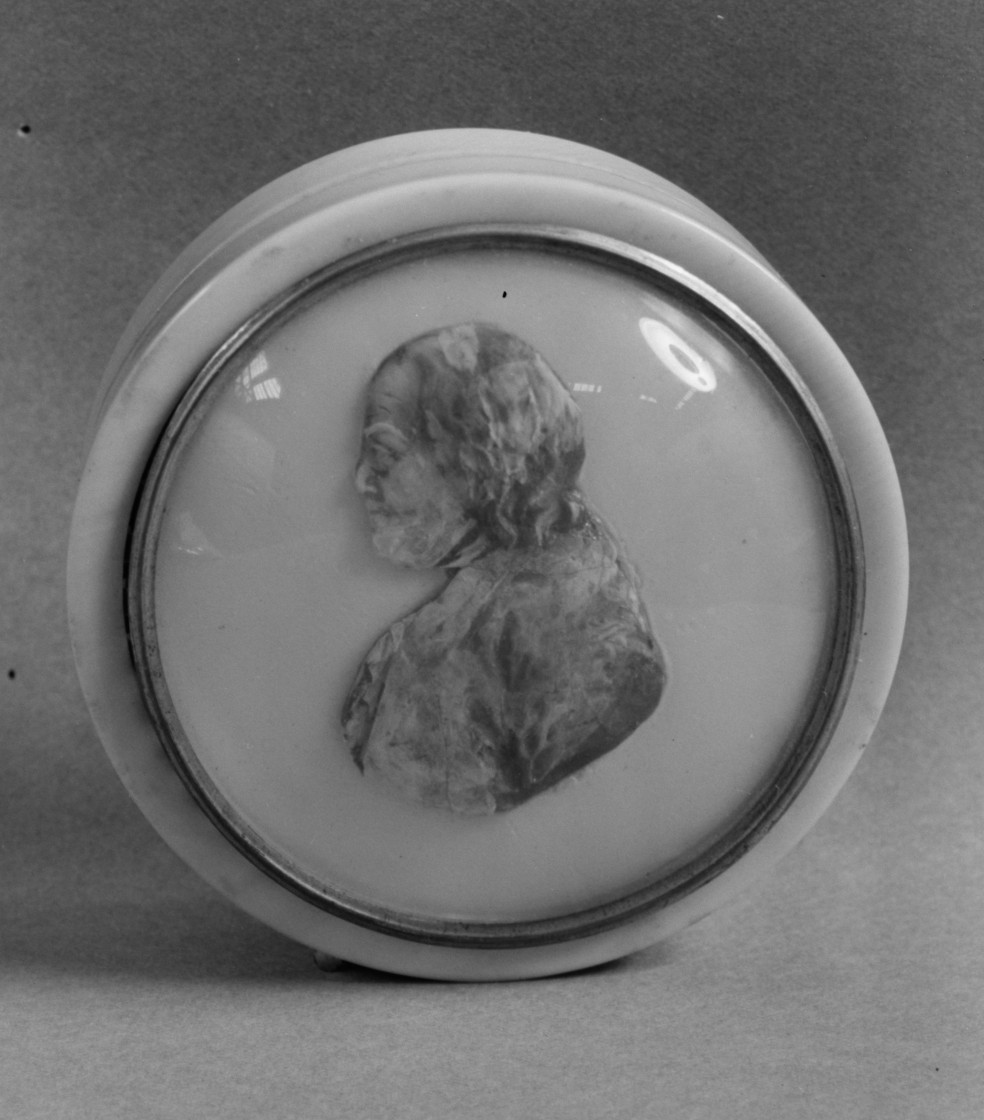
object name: box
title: Benjamin Franklin (1706–1790)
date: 1767-1800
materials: brass, glass, ivory, porcelain, shell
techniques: lining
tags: benjamin franklin,profiles